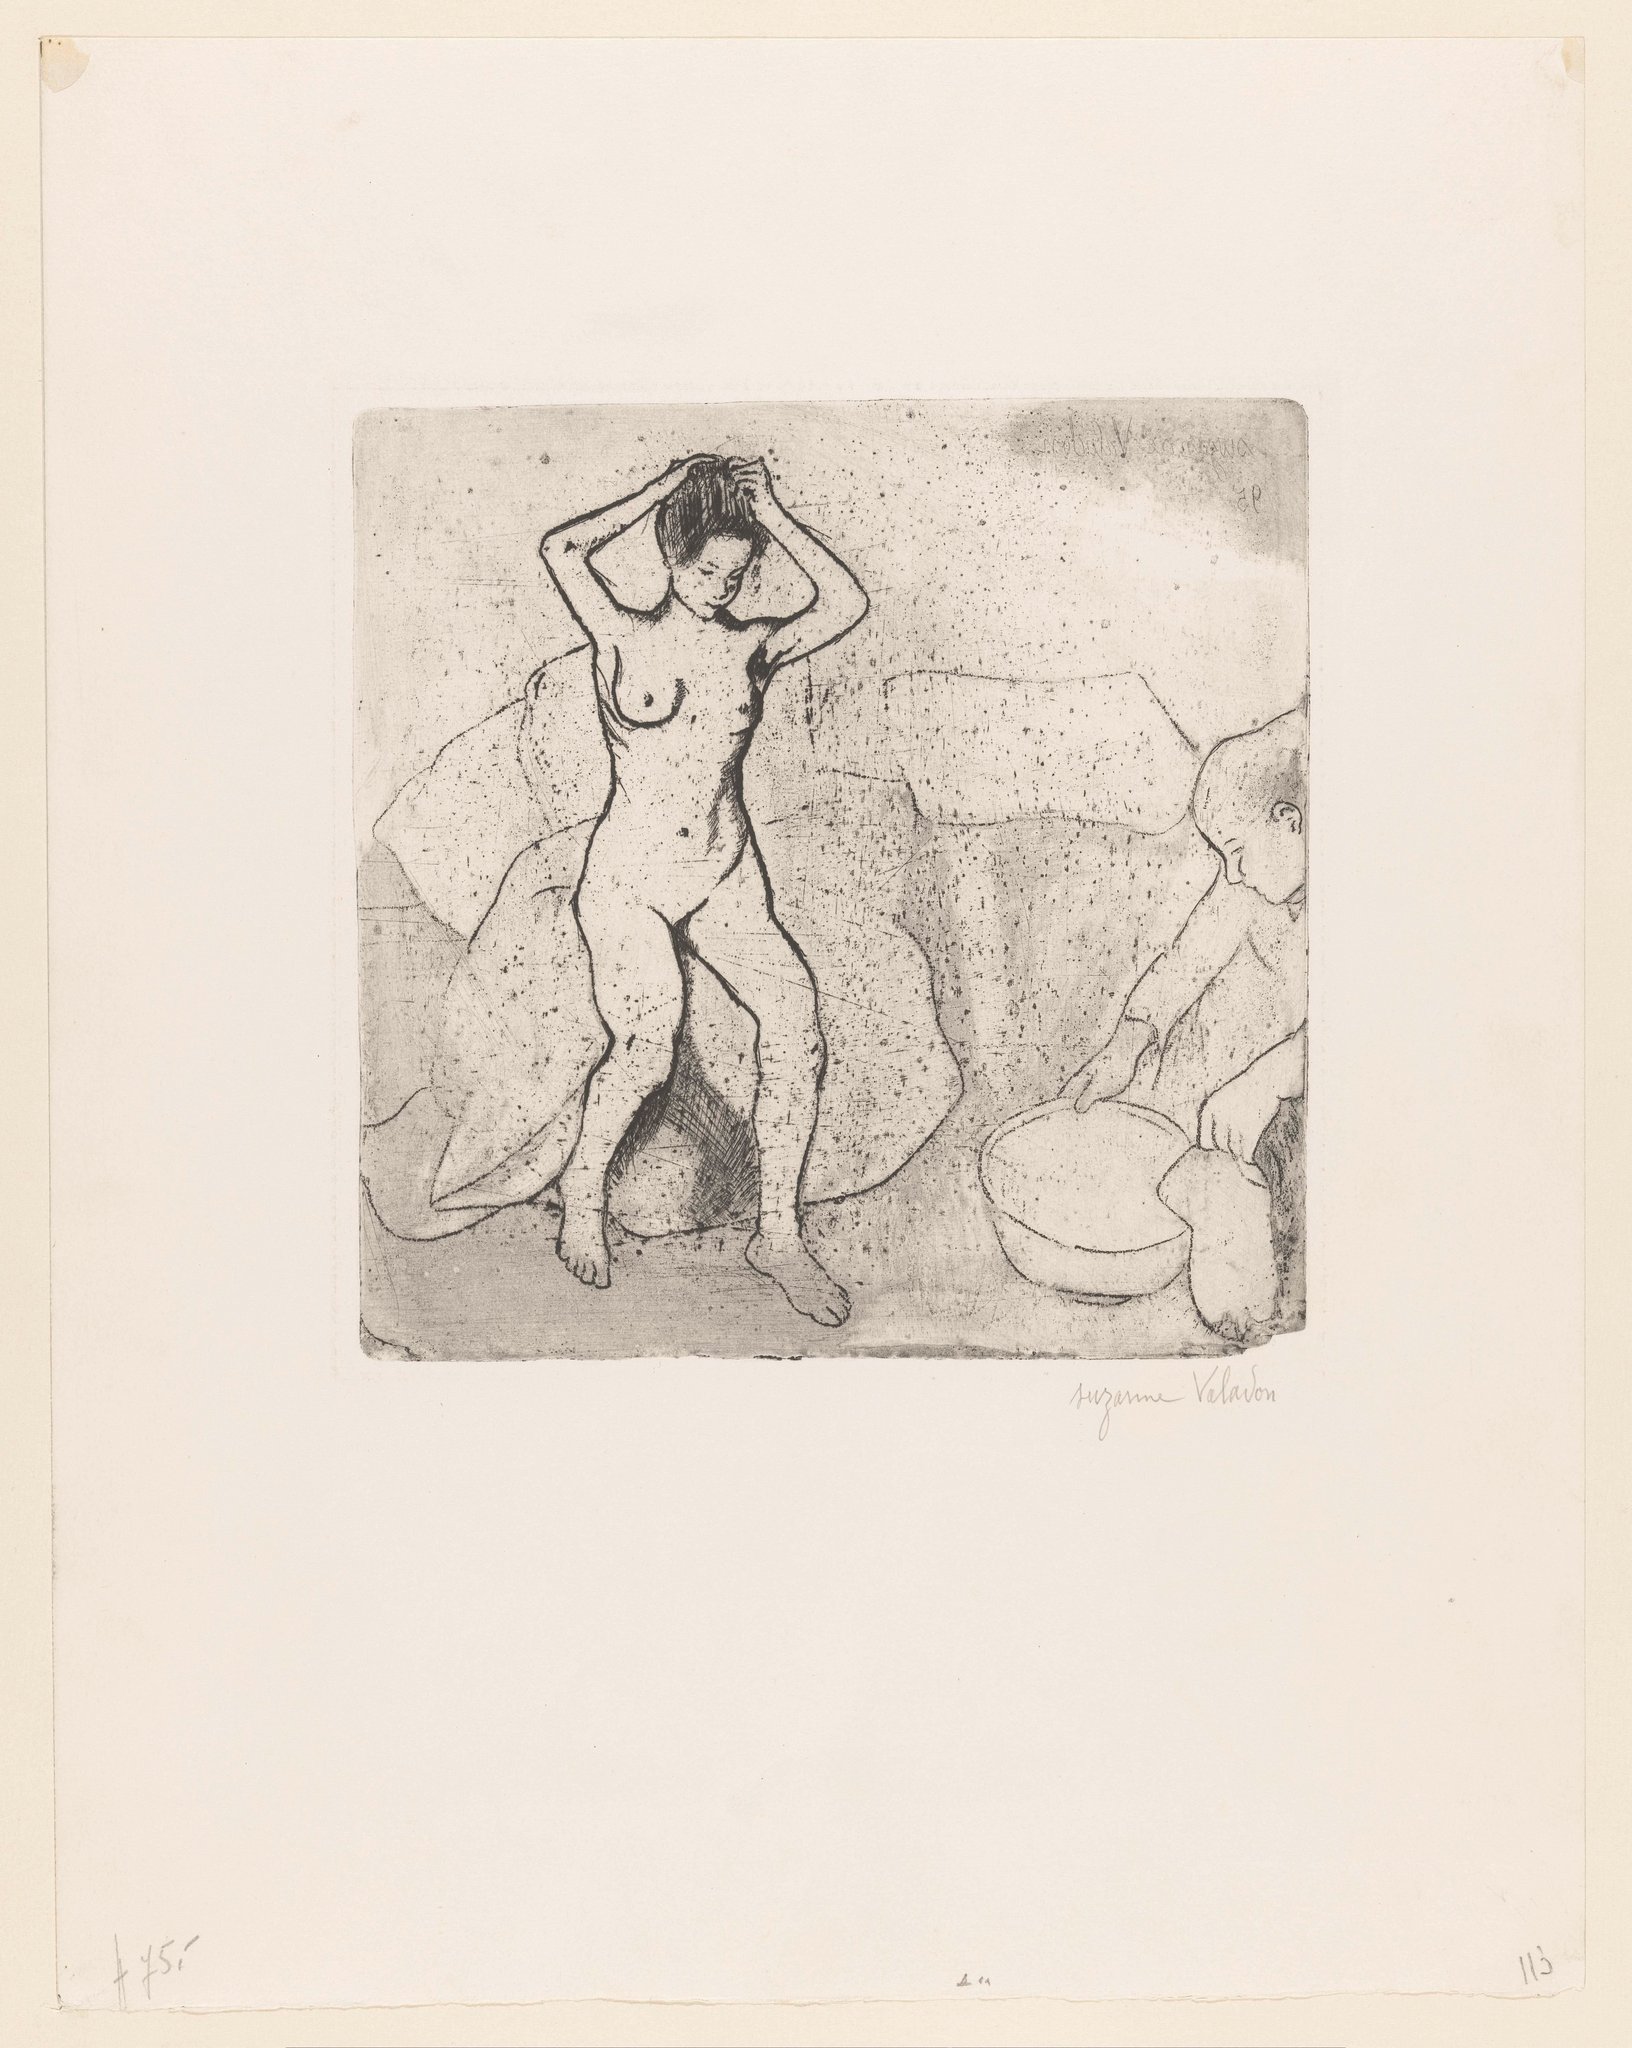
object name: print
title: Catherine prépare le tub et Louise nue se coiffe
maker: suzanne valadon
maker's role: print maker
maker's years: 1865-1938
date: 1895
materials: paper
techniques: drypoint, etching, intaglio, soft ground etching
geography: france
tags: taking a bath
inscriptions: collector's mark: Lugt 2228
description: Dezelfde prent die zich bevindt in het Centre Pompidou te Parijs, inv. nr. AM 1974-253 (6), maakt deel uit van een portfolio van achttien prenten, voorzien van een tekst door C. Roger-Marx.